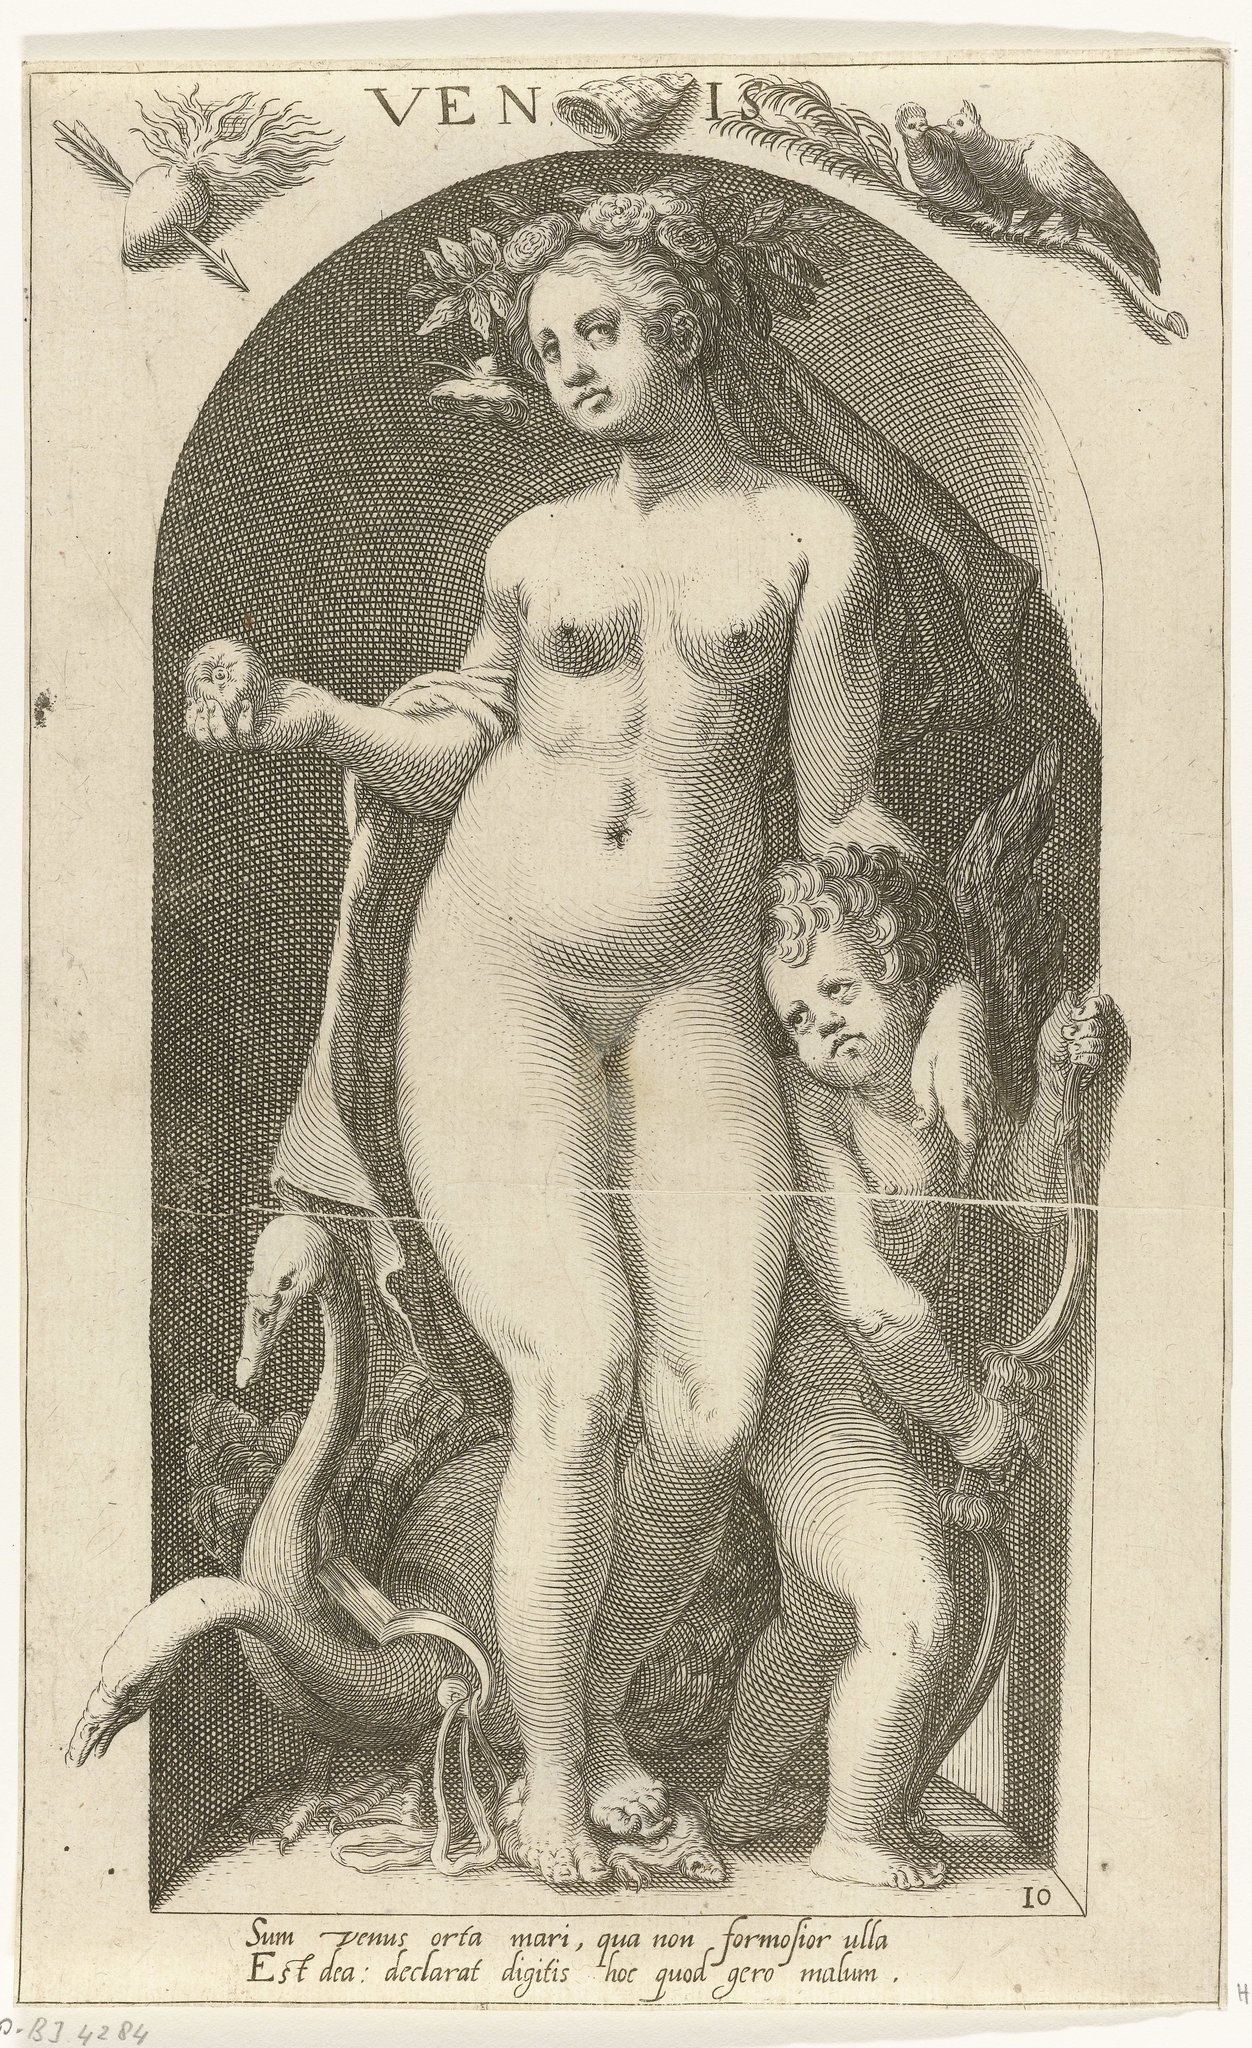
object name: print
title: Venus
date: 1598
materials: paper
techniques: engraving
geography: haarlem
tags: (story of) venus (aphrodite)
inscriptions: collector's mark: Lugt 2228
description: Een beeld van de godin van de liefde Venus, met haar metgezel Amor in een nis geplaatst. Naast hen twee zwanen die gewoonlijk de kar van Venus trekken. Aan de muur tortelduiven en een brandend haart als symbolen voor de liefde en een schelp die herinnert aan Venus geboorte uit de zee. Onder de voorstelling een Latijns onderschrift.